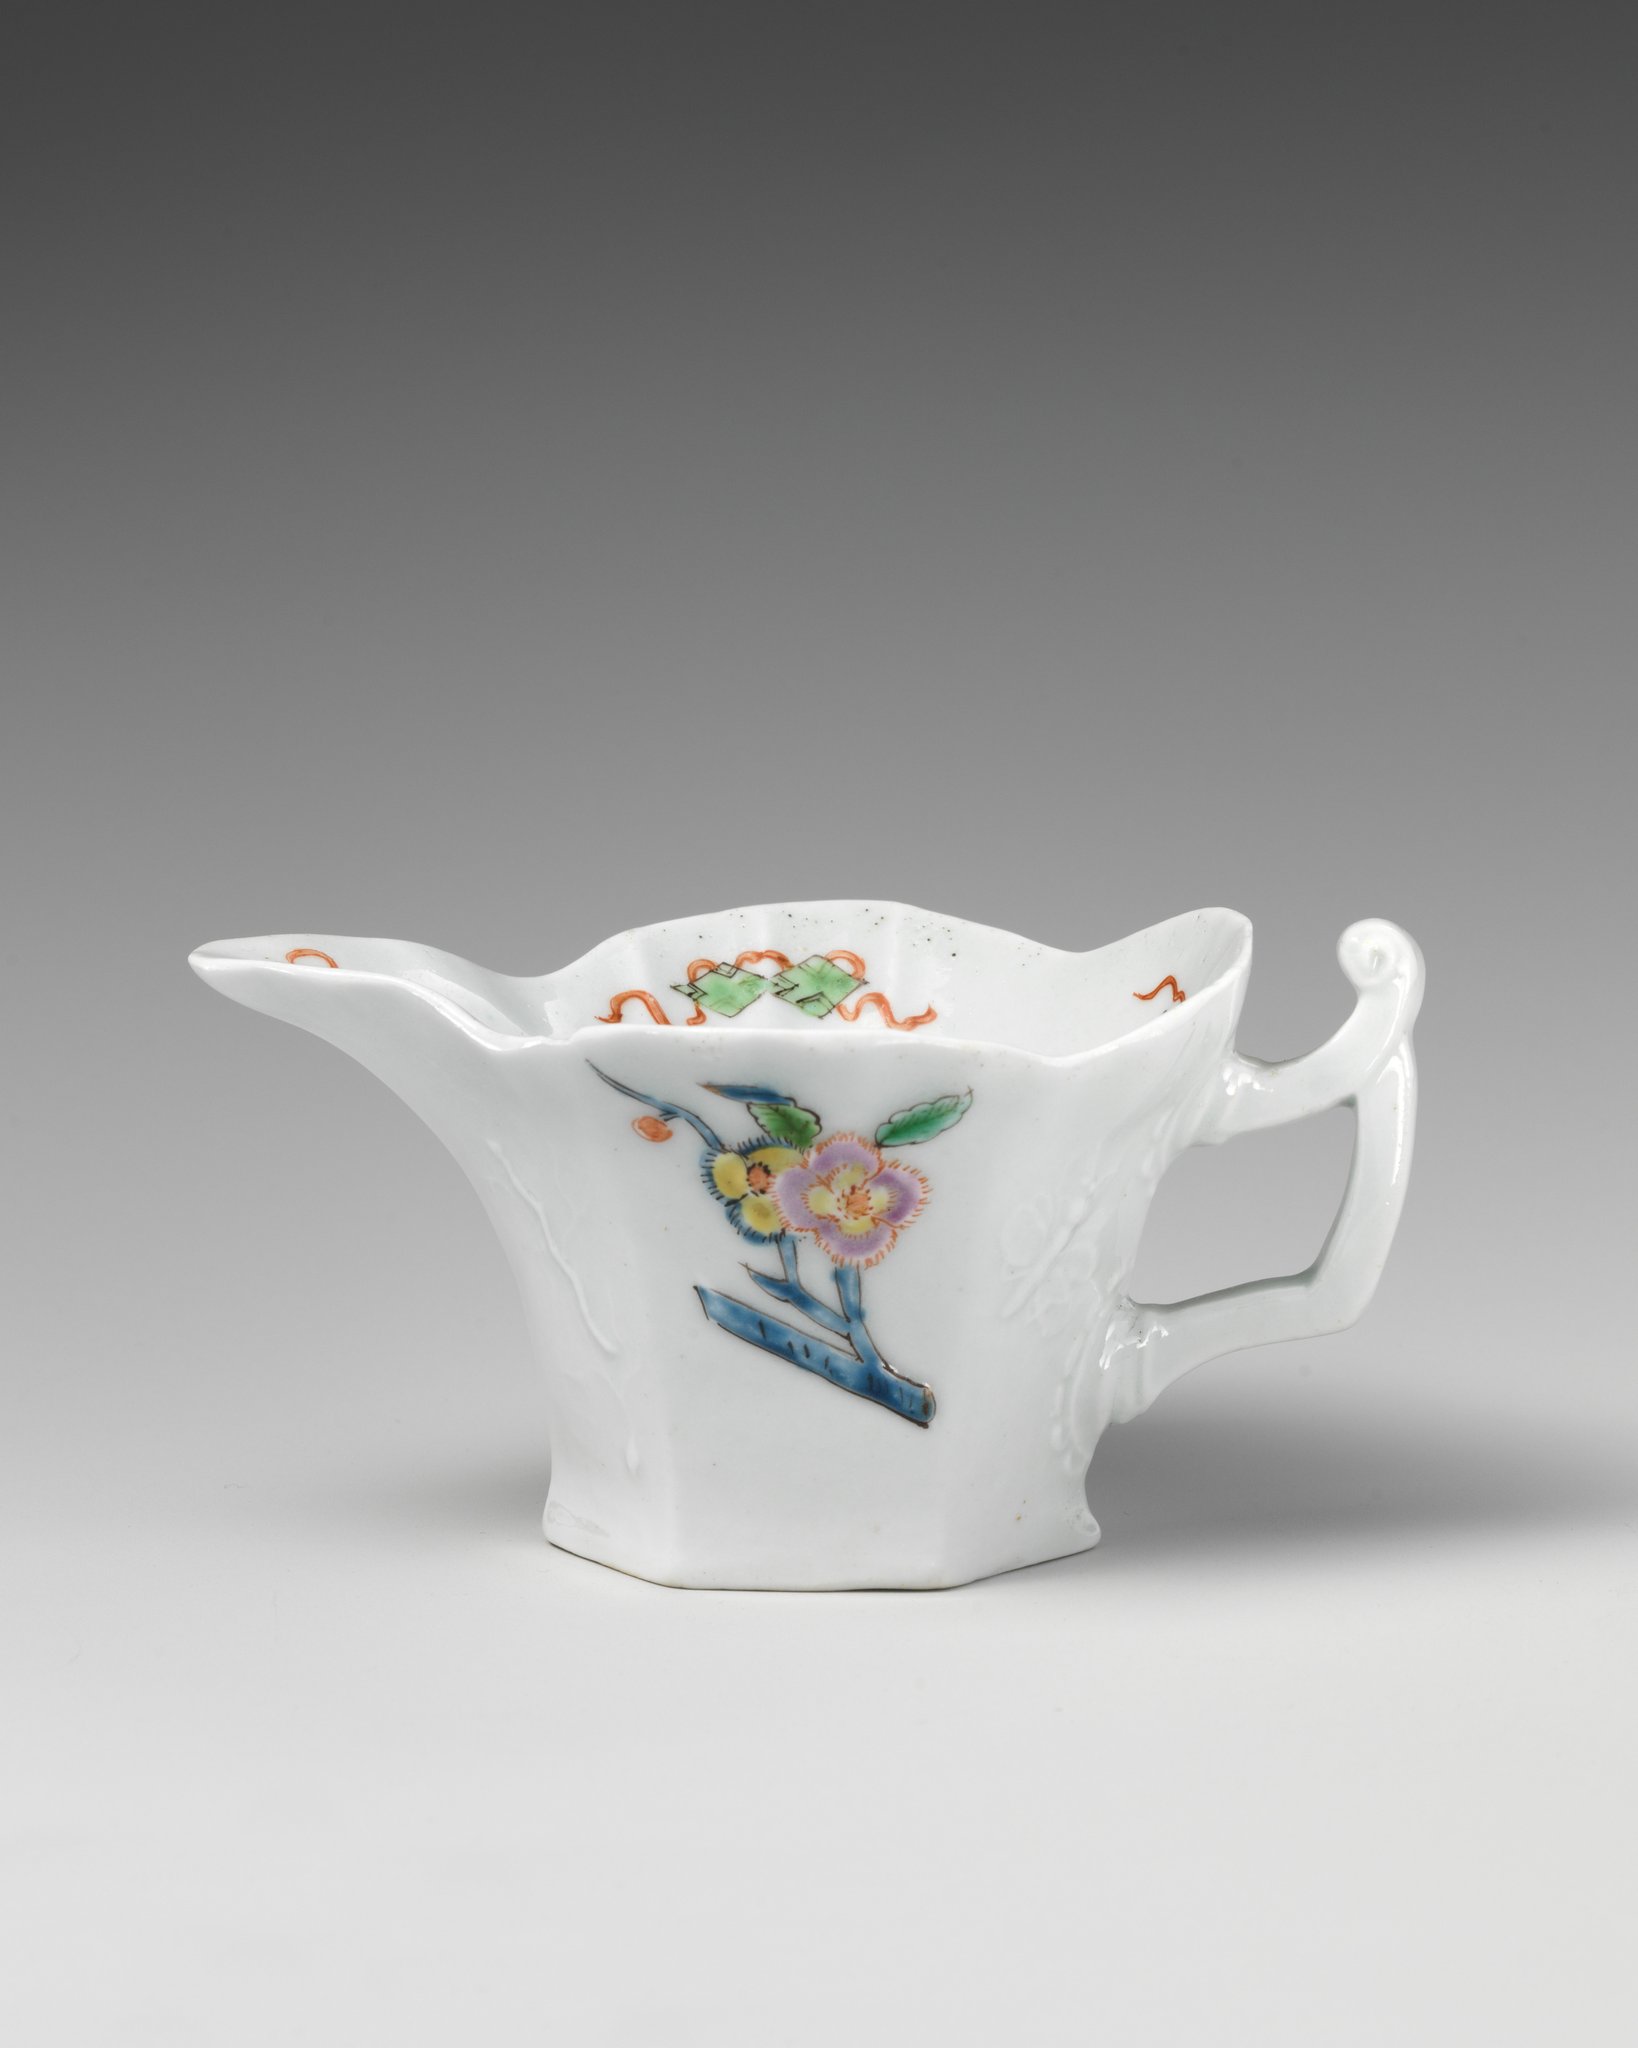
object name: creamboat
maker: worcester factory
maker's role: factory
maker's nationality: british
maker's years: 1751-2008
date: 1753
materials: soft paste porcelain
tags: flowers